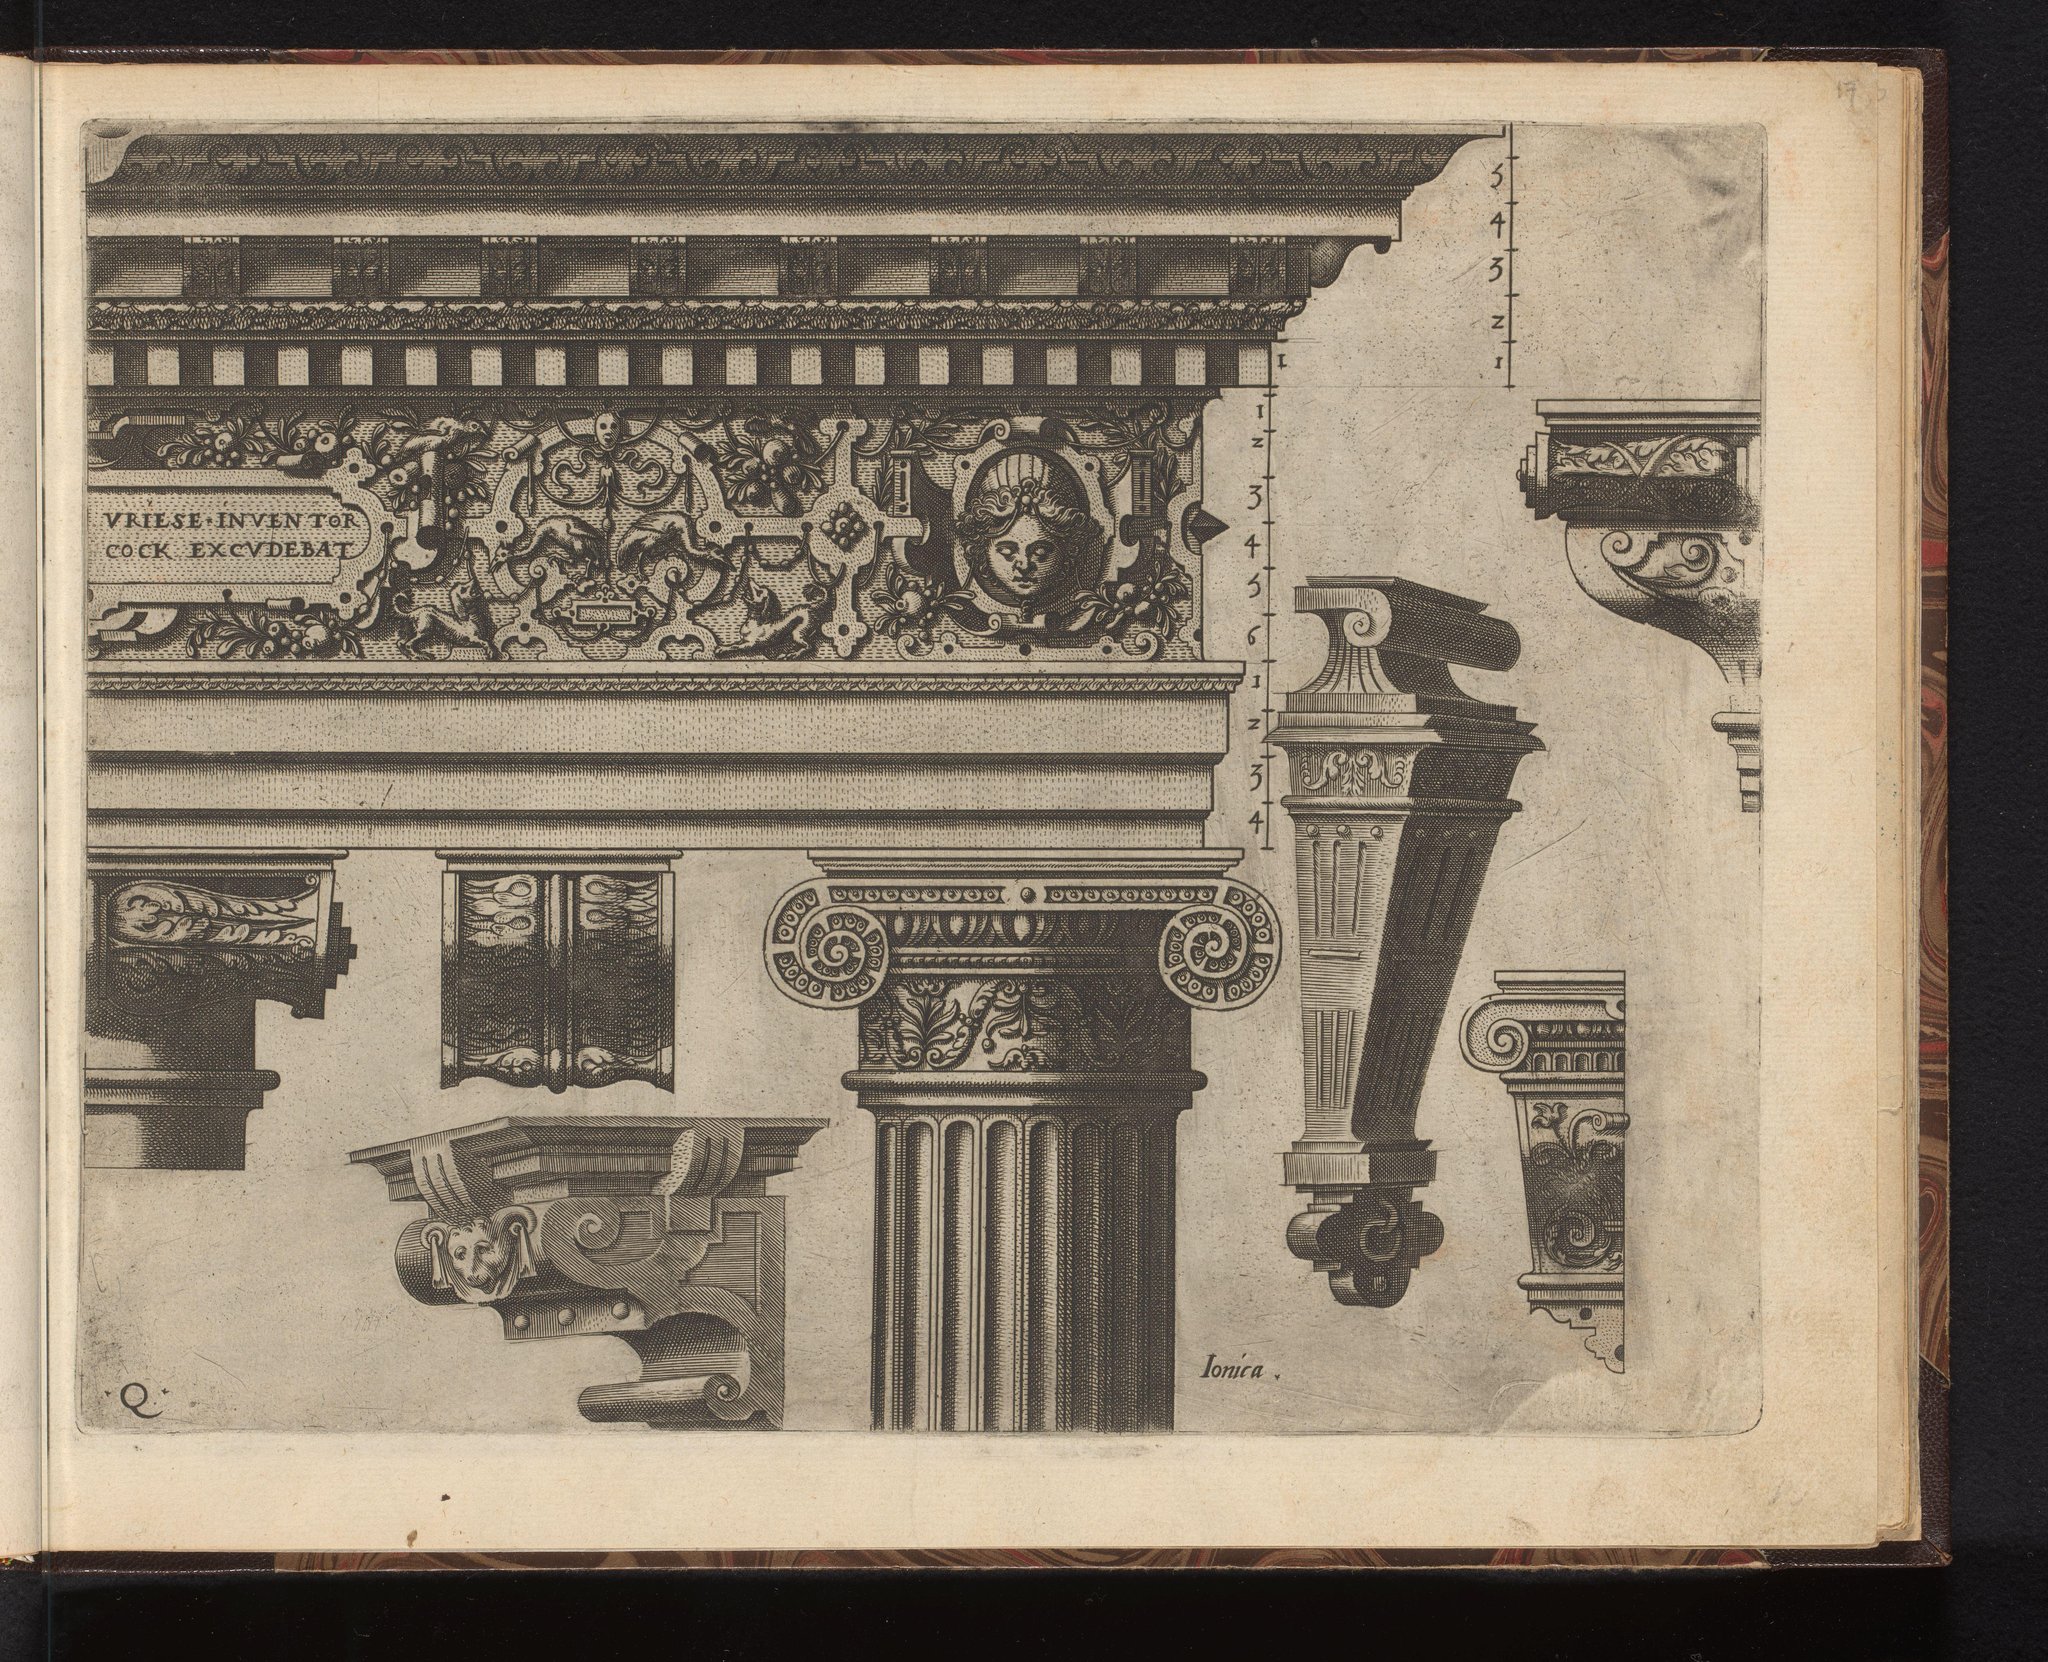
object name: ornament print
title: Den eersten boeck ghemaeckt op de twee Colomnen Dorica en Ionica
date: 1565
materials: paper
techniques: etching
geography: antwerp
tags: other architectural details (console), other architectural details (entablature), half-column, pilaster ~ architecture, ionic order ~ architecture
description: Ionisch hoofdgestel. Het fries is gedecoreerd met rolwerk, beslagwerk, guilandes, vogels, hondjes en rechts een mascaron. Daarbij vijf consoles en een pilaster. Op de prent is vier maal een schaalverdeling aangegeven. Blad Q. De prent maakt deel uit van een album.